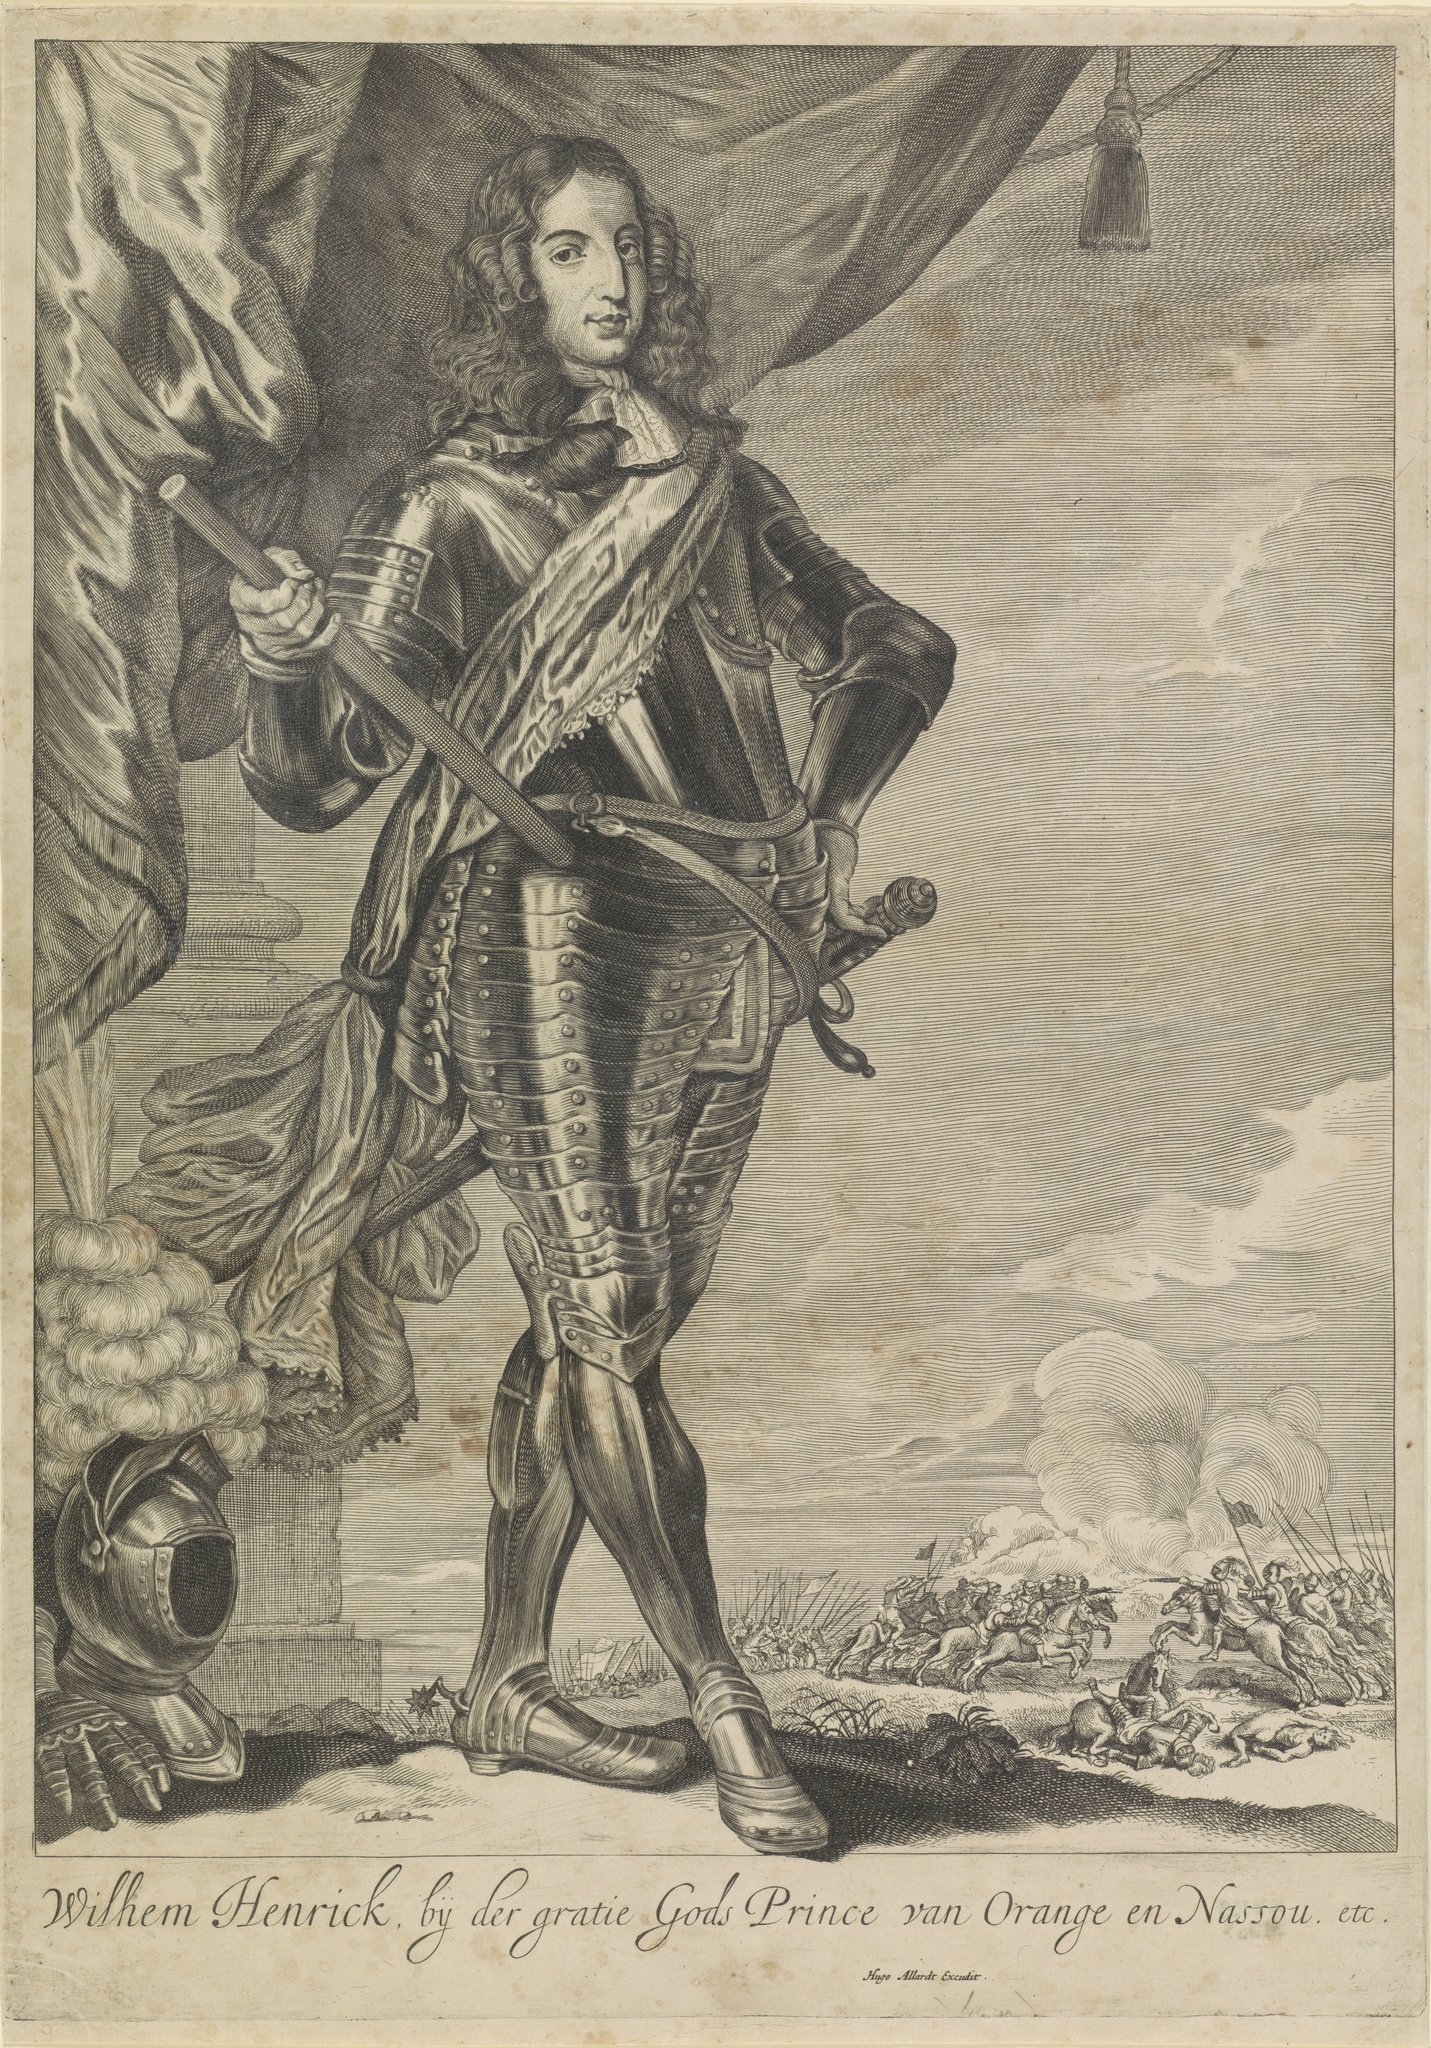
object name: print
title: Portret van Willem III, prins van Oranje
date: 1670-1684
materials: paper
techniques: engraving, etching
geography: amsterdam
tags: william iii (prince of orange and king of england, scotland, and ireland)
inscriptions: collector's mark: Lugt 963, collector's mark: Lugt 2165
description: De hier vermelde titel verwijst naar de hoogst verkregen titel van de geportretteerde, niet per se naar de titel die de geportretteerde op deze voorstelling draagt.